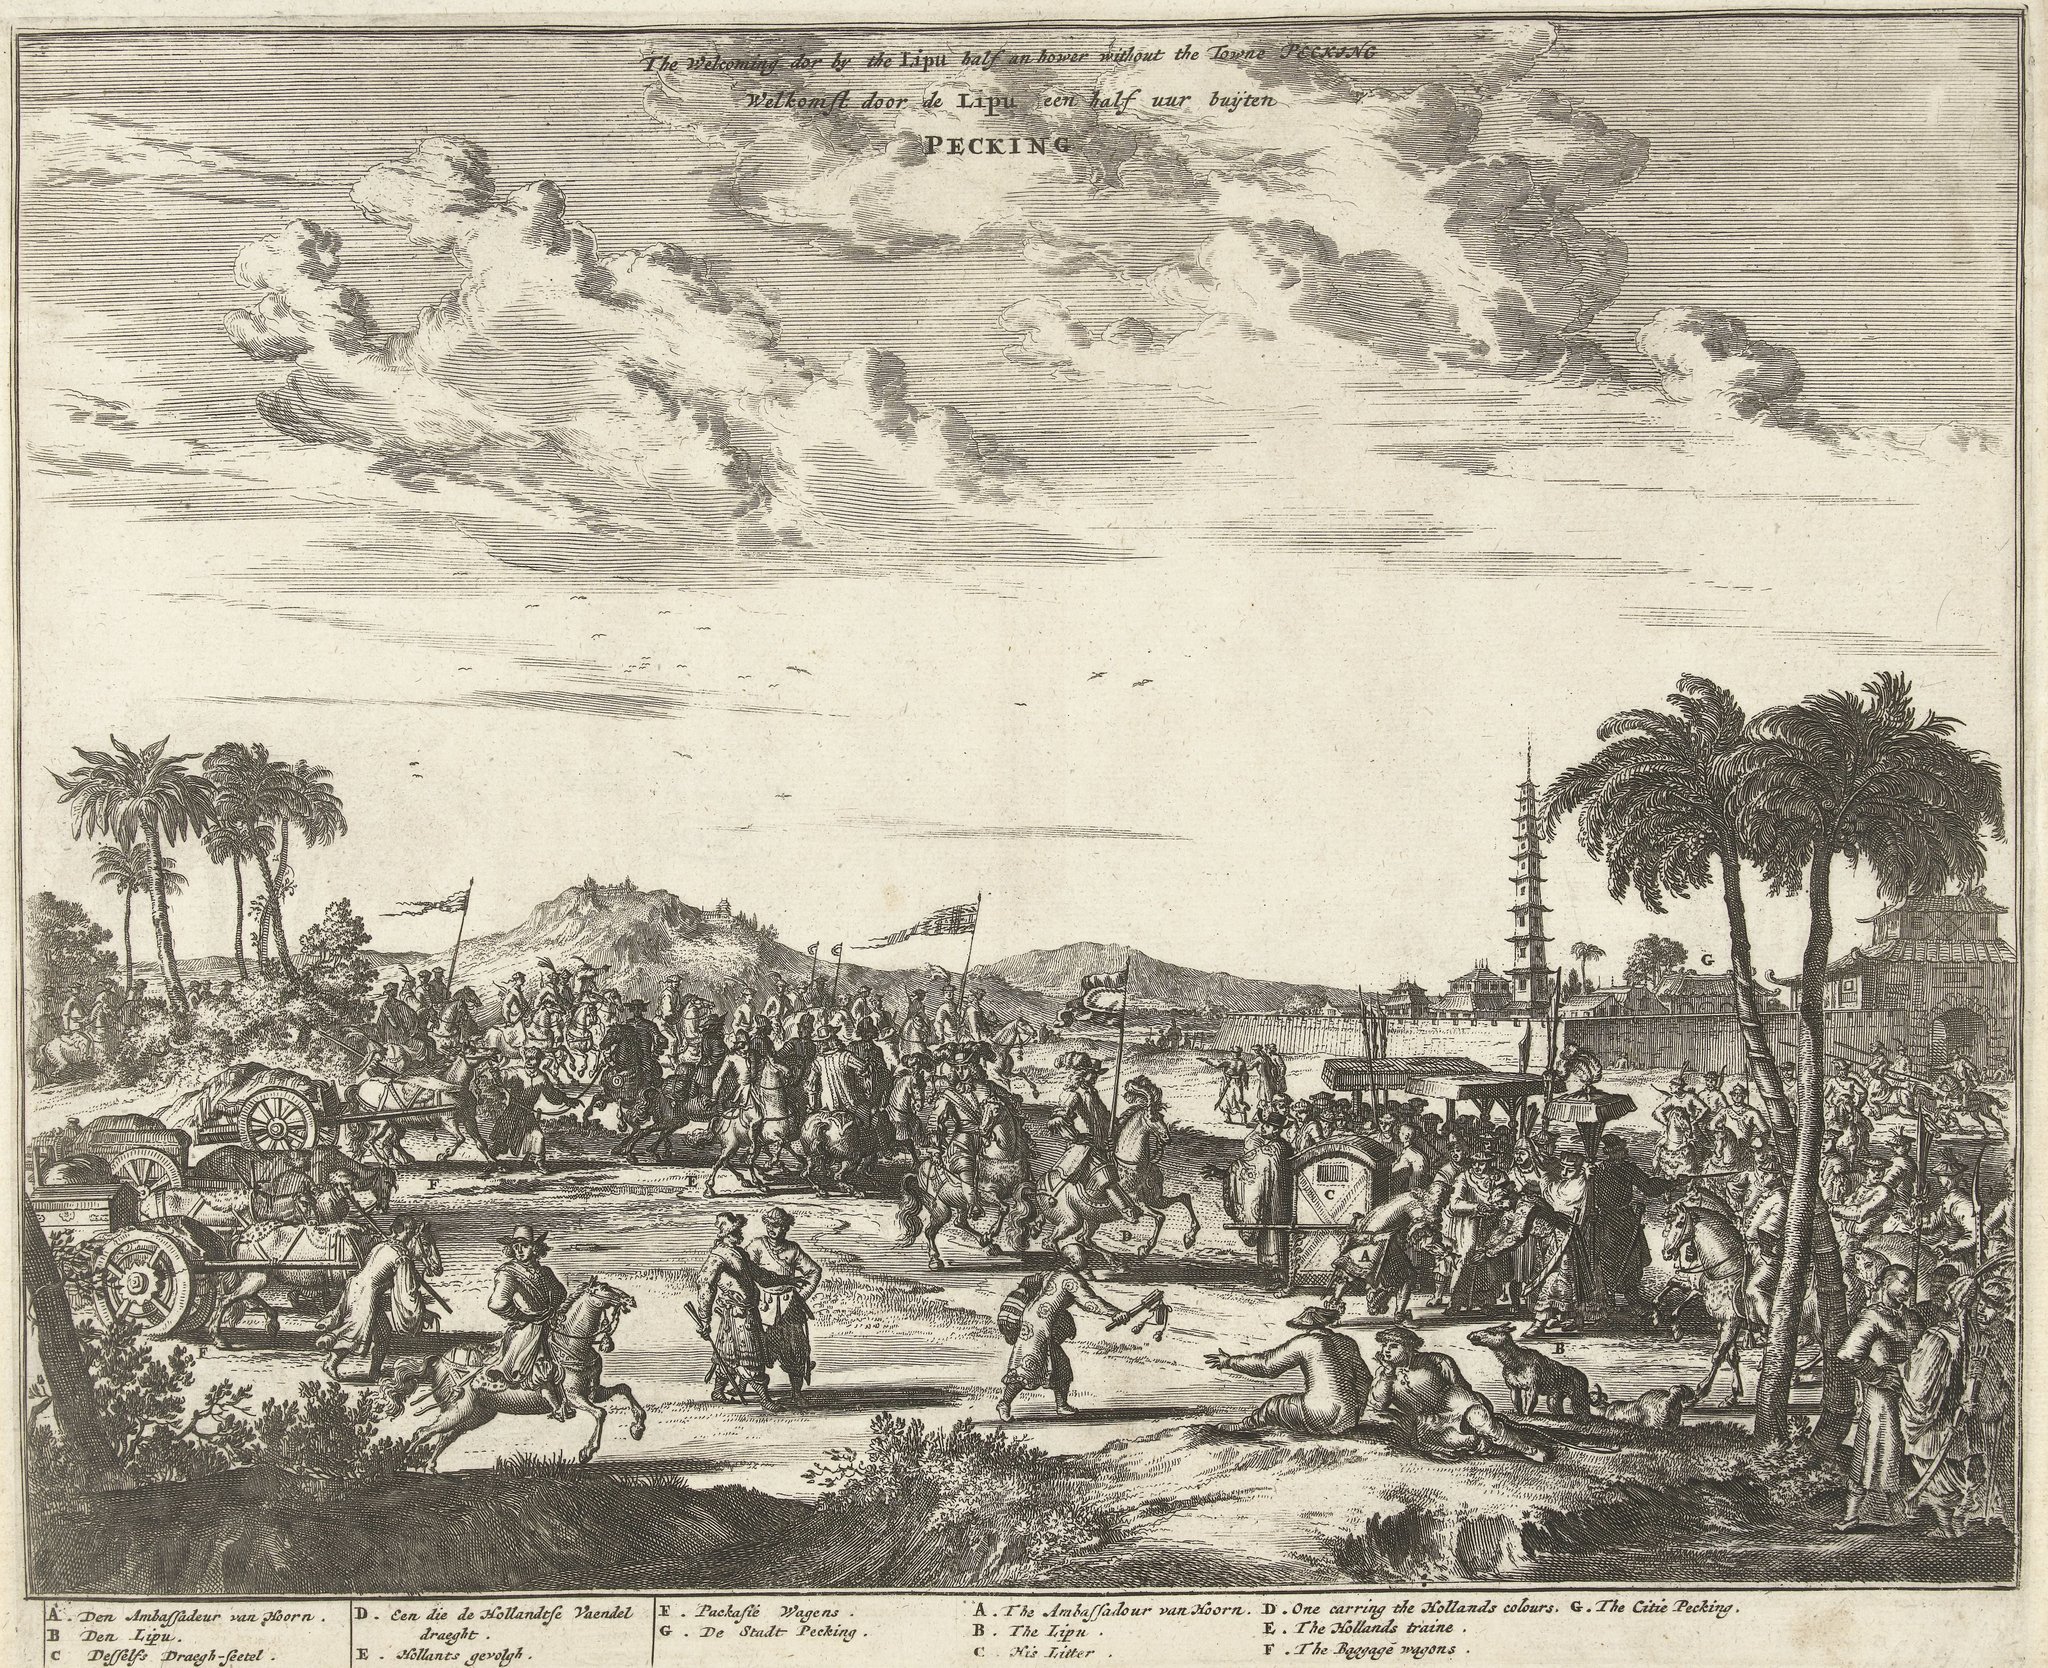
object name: print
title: The welcoming dor by the Lipu half an hower without the Towne Pecking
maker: Anonymous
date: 1668-1670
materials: paper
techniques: engraving, etching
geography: northern netherlands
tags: being welcomed ~ travelling, china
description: Gebruikt als illustratie in: O. Dapper, Gedenkwaerdig bedryf der Nederlandsche Oost-Indische Maetschappye, op de kuste en in het Keizerrijk van Taising of Sina: behelzende het 2e gezandschap aen den Onder-Koning Singlamong ... Vervolgt met een verhael van het voorgevallen des jaers 1663 en 1664 op de kuste van Sina ... en het 3e gezandschap aan Konchy, Tartarsche Keizer van Sina en Oost Tartarye ... beneffens een beschryving van geheel Sina, J. van Meurs, Amsterdam 1670, p. 346/347. Niet in Frederik Muller; door het RPK toegevoegd nummer.